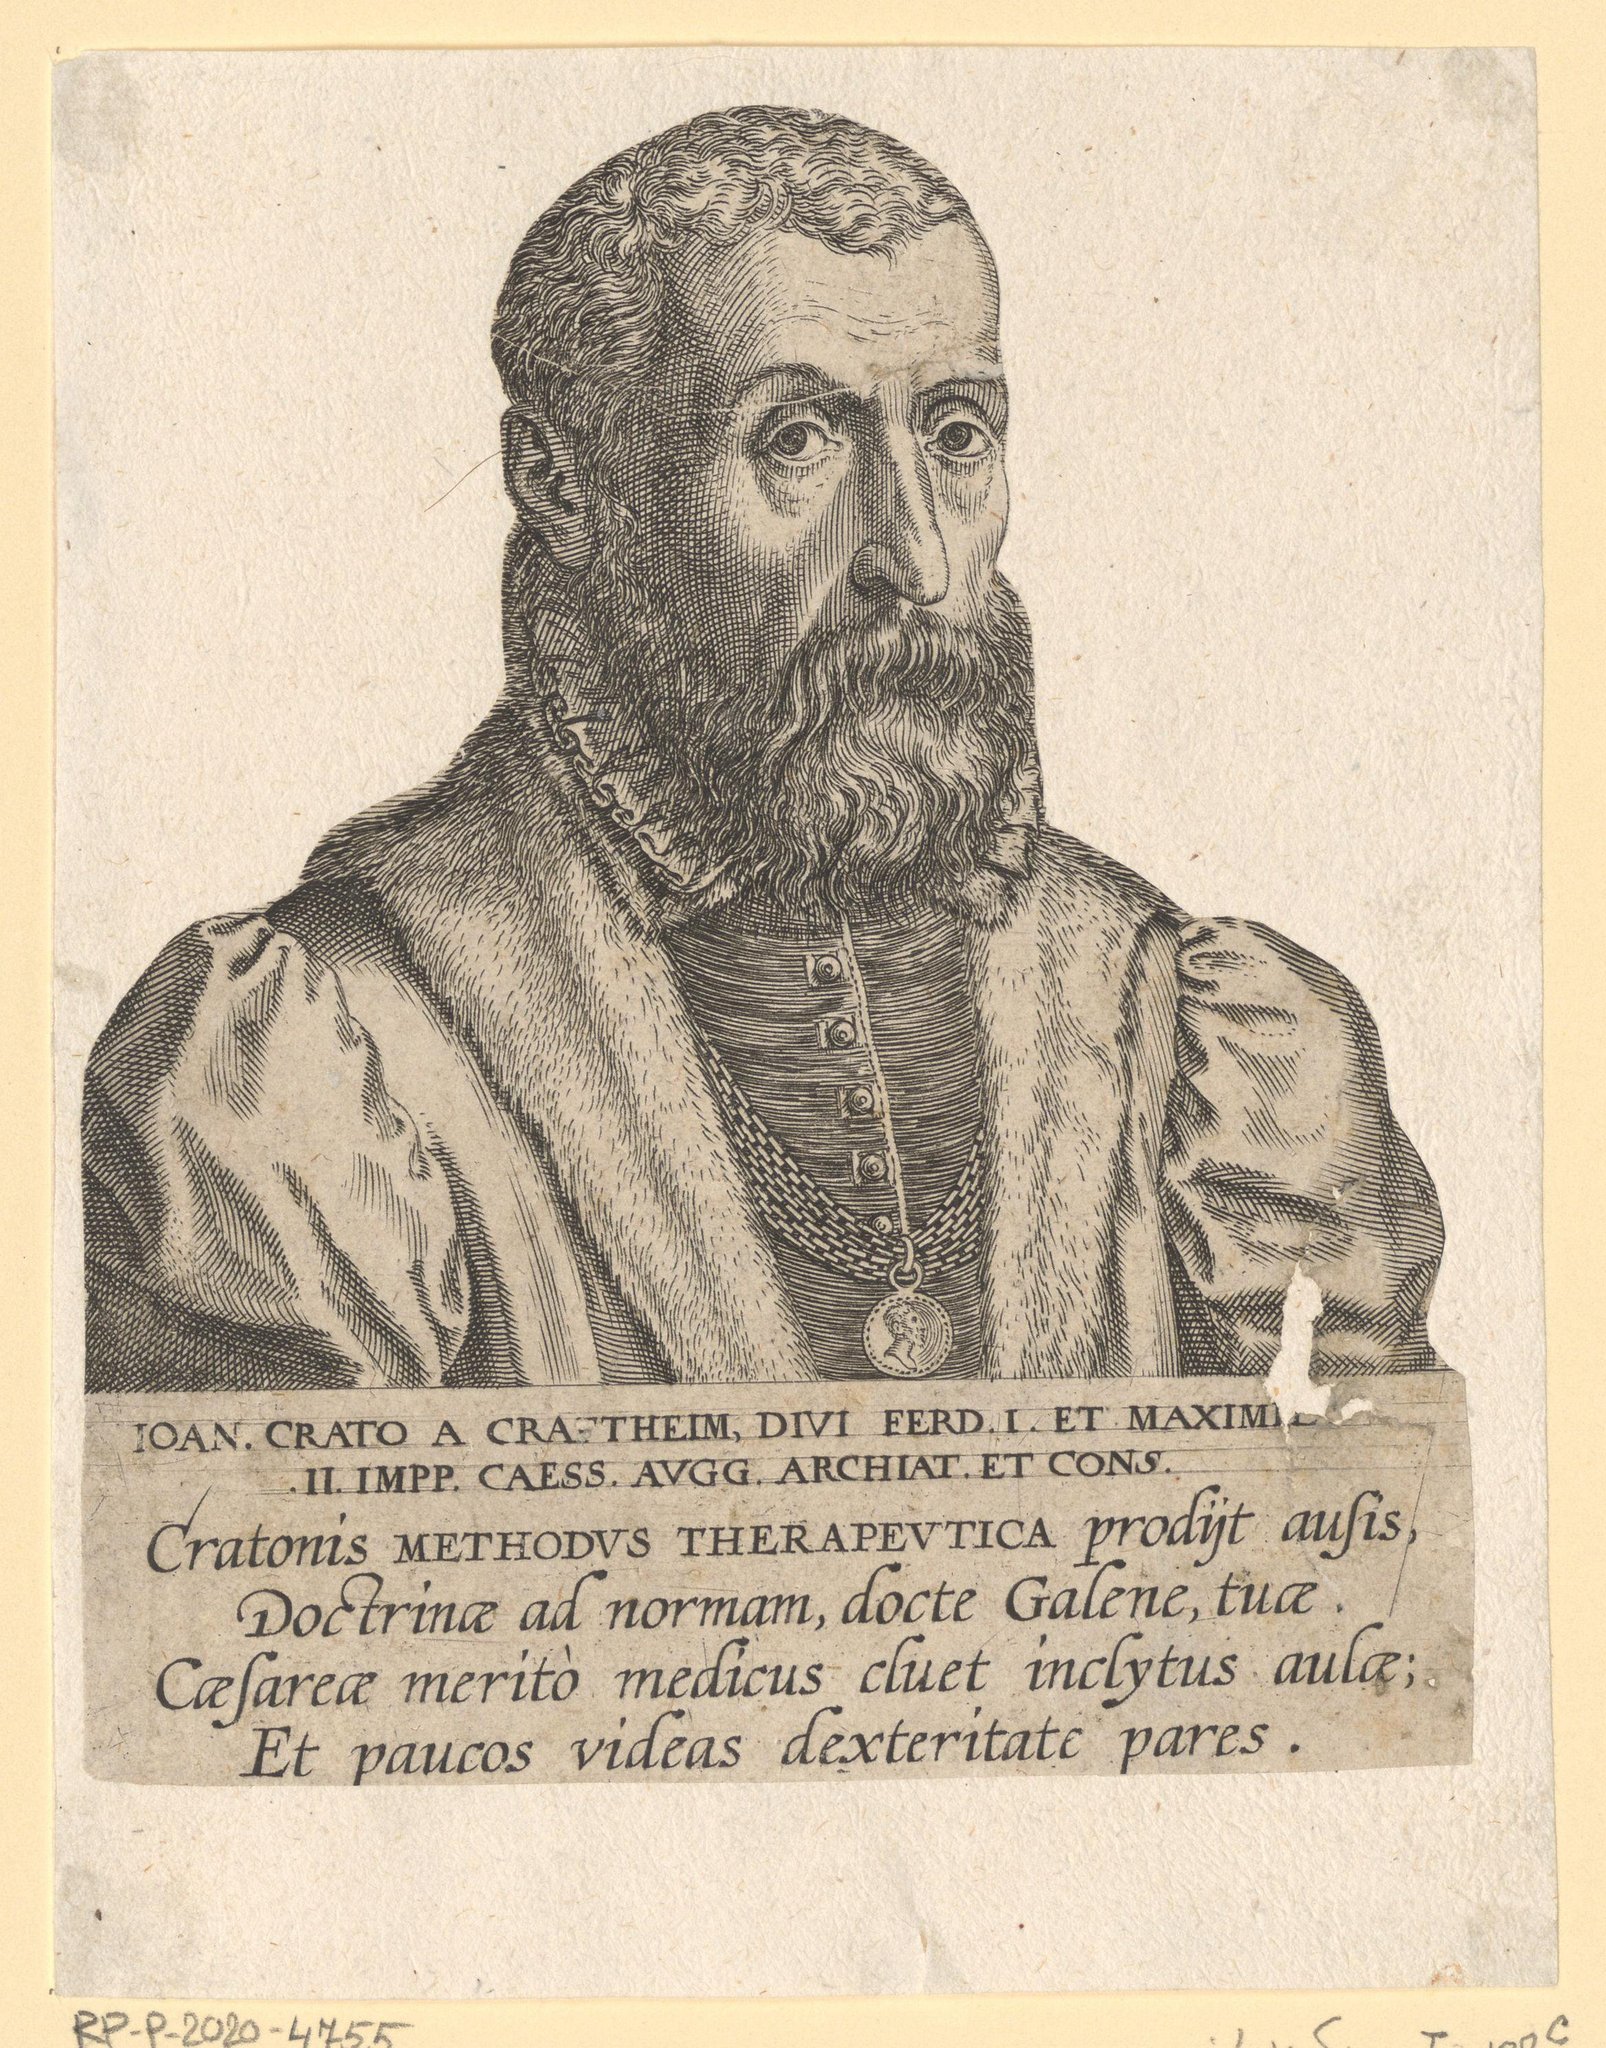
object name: print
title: Portret van Johannes Crato von Krafftheim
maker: Anonymous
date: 1550-1649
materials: paper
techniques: engraving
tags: historical persons